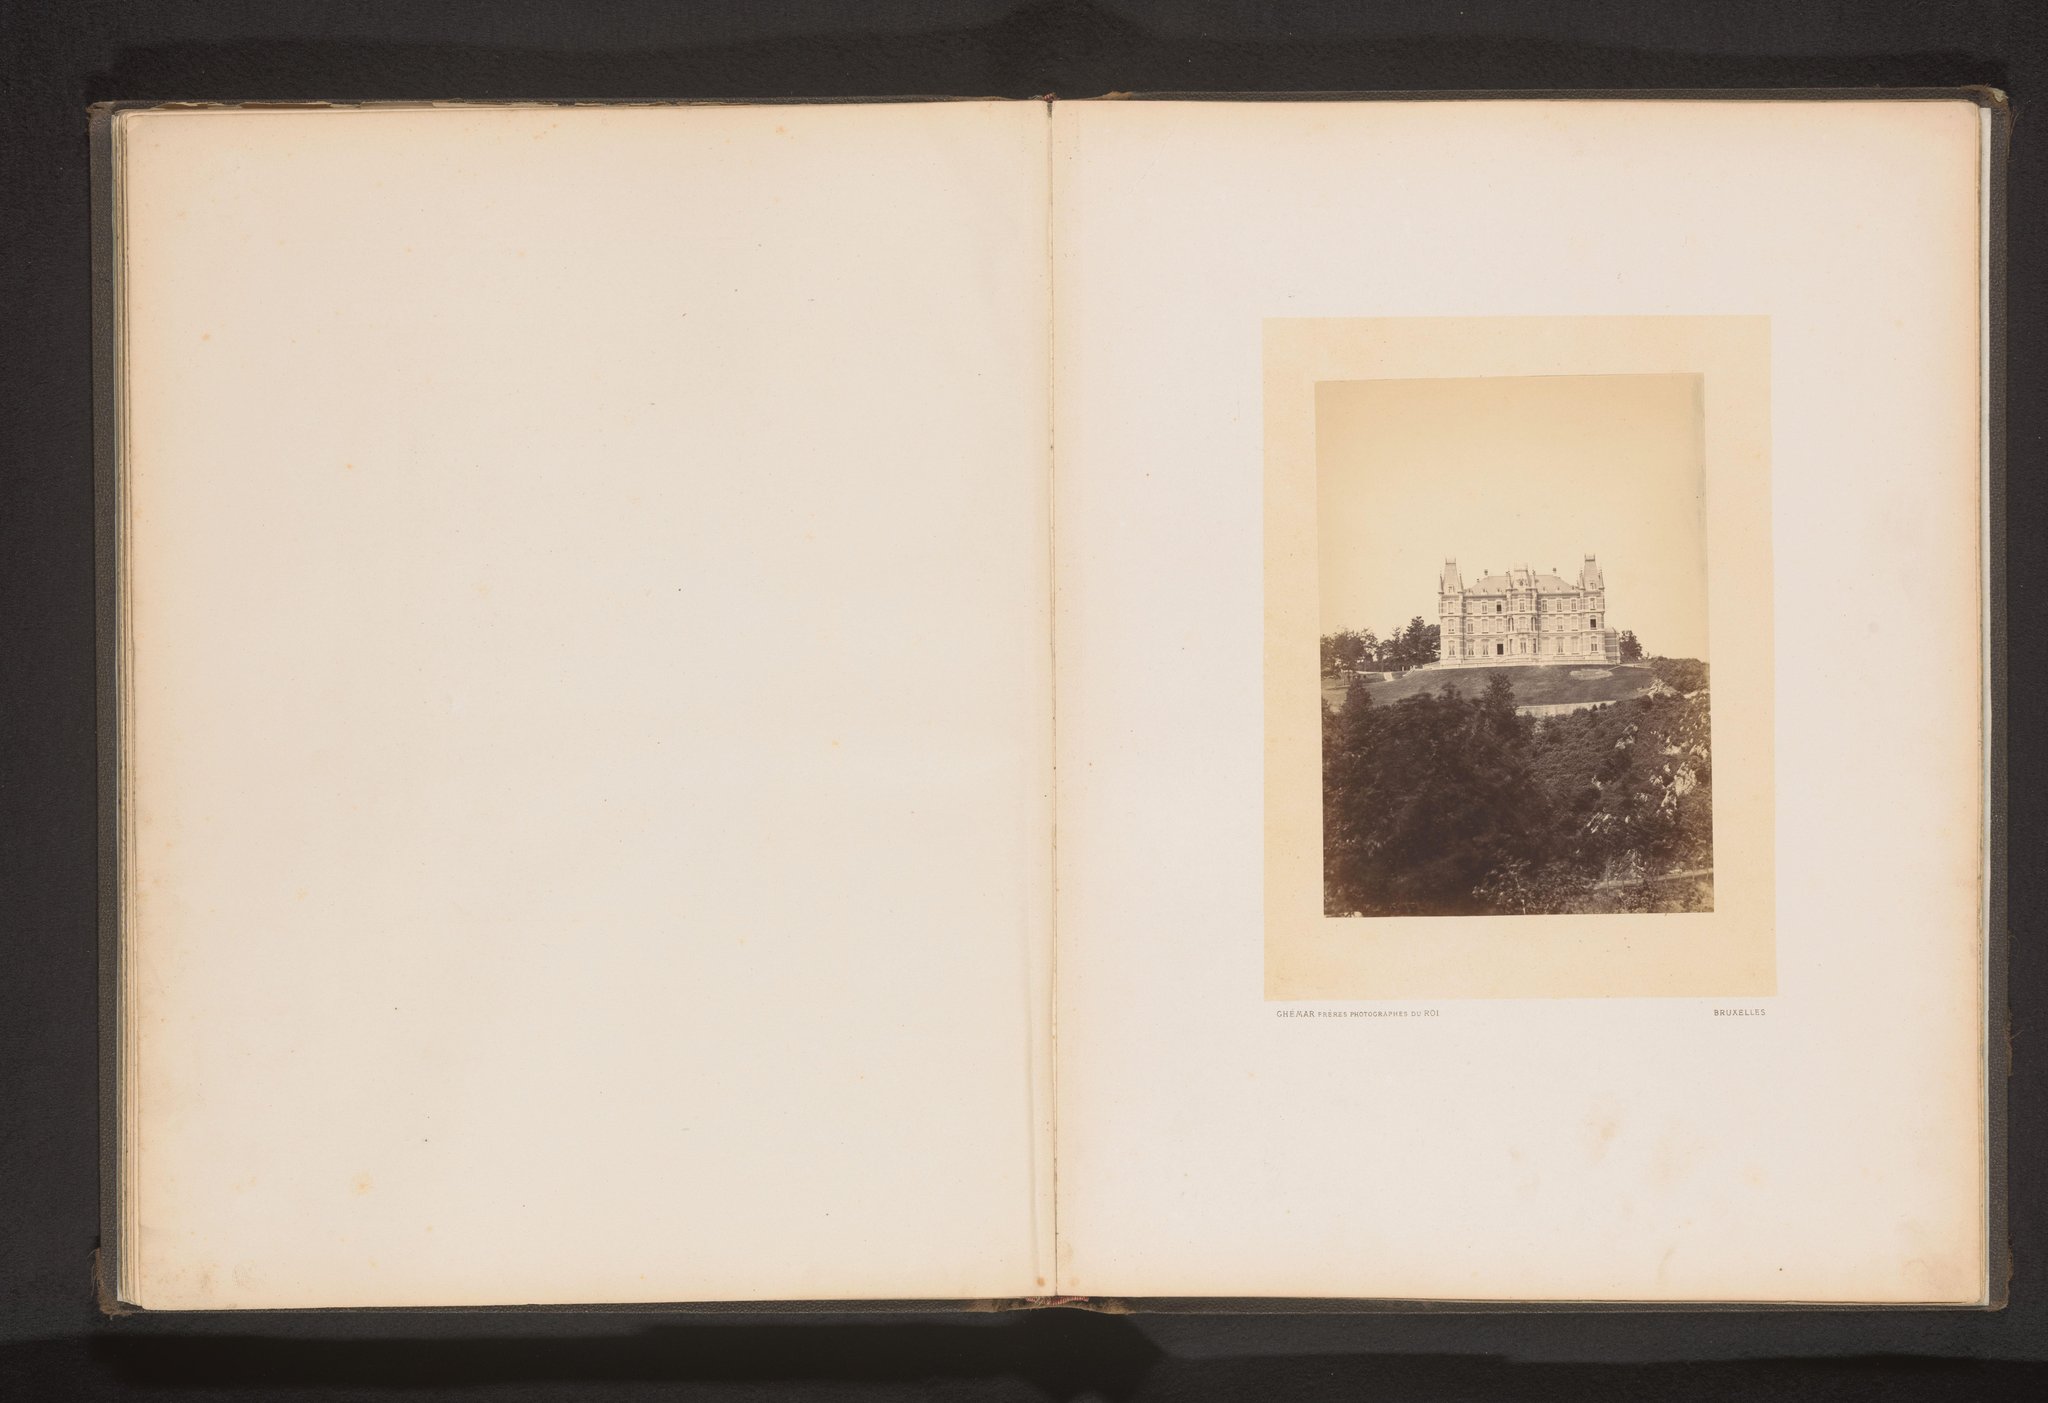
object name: photograph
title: Gezicht op Château de Marlagne te Wépion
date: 1862-1867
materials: photographic support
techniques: albumen print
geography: wépion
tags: landscape with tower or castle